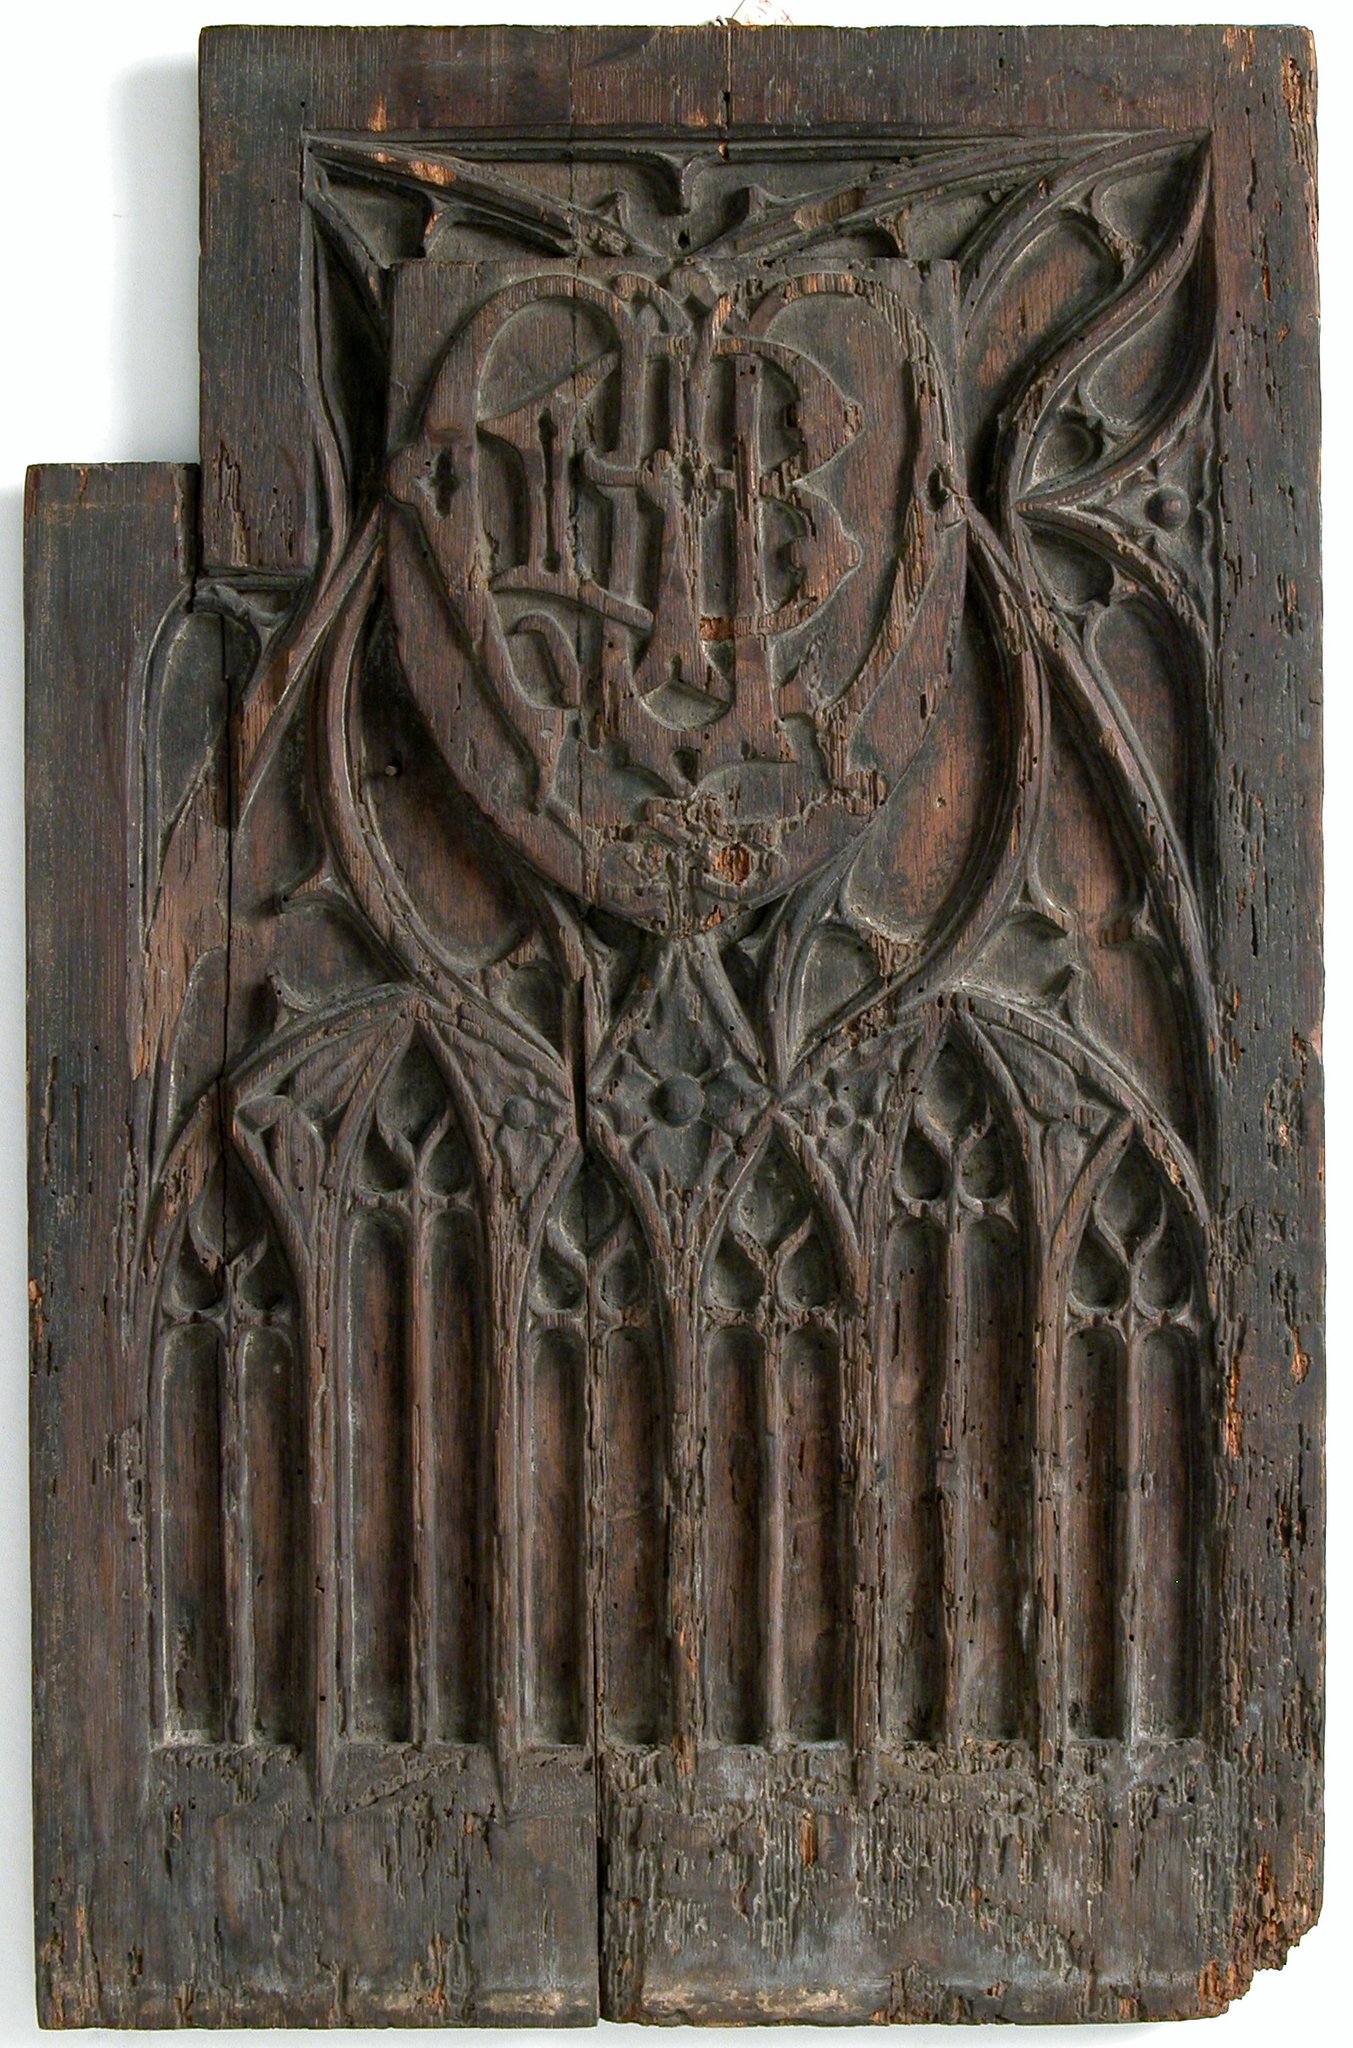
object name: panel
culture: french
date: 1401-1500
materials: wood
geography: france